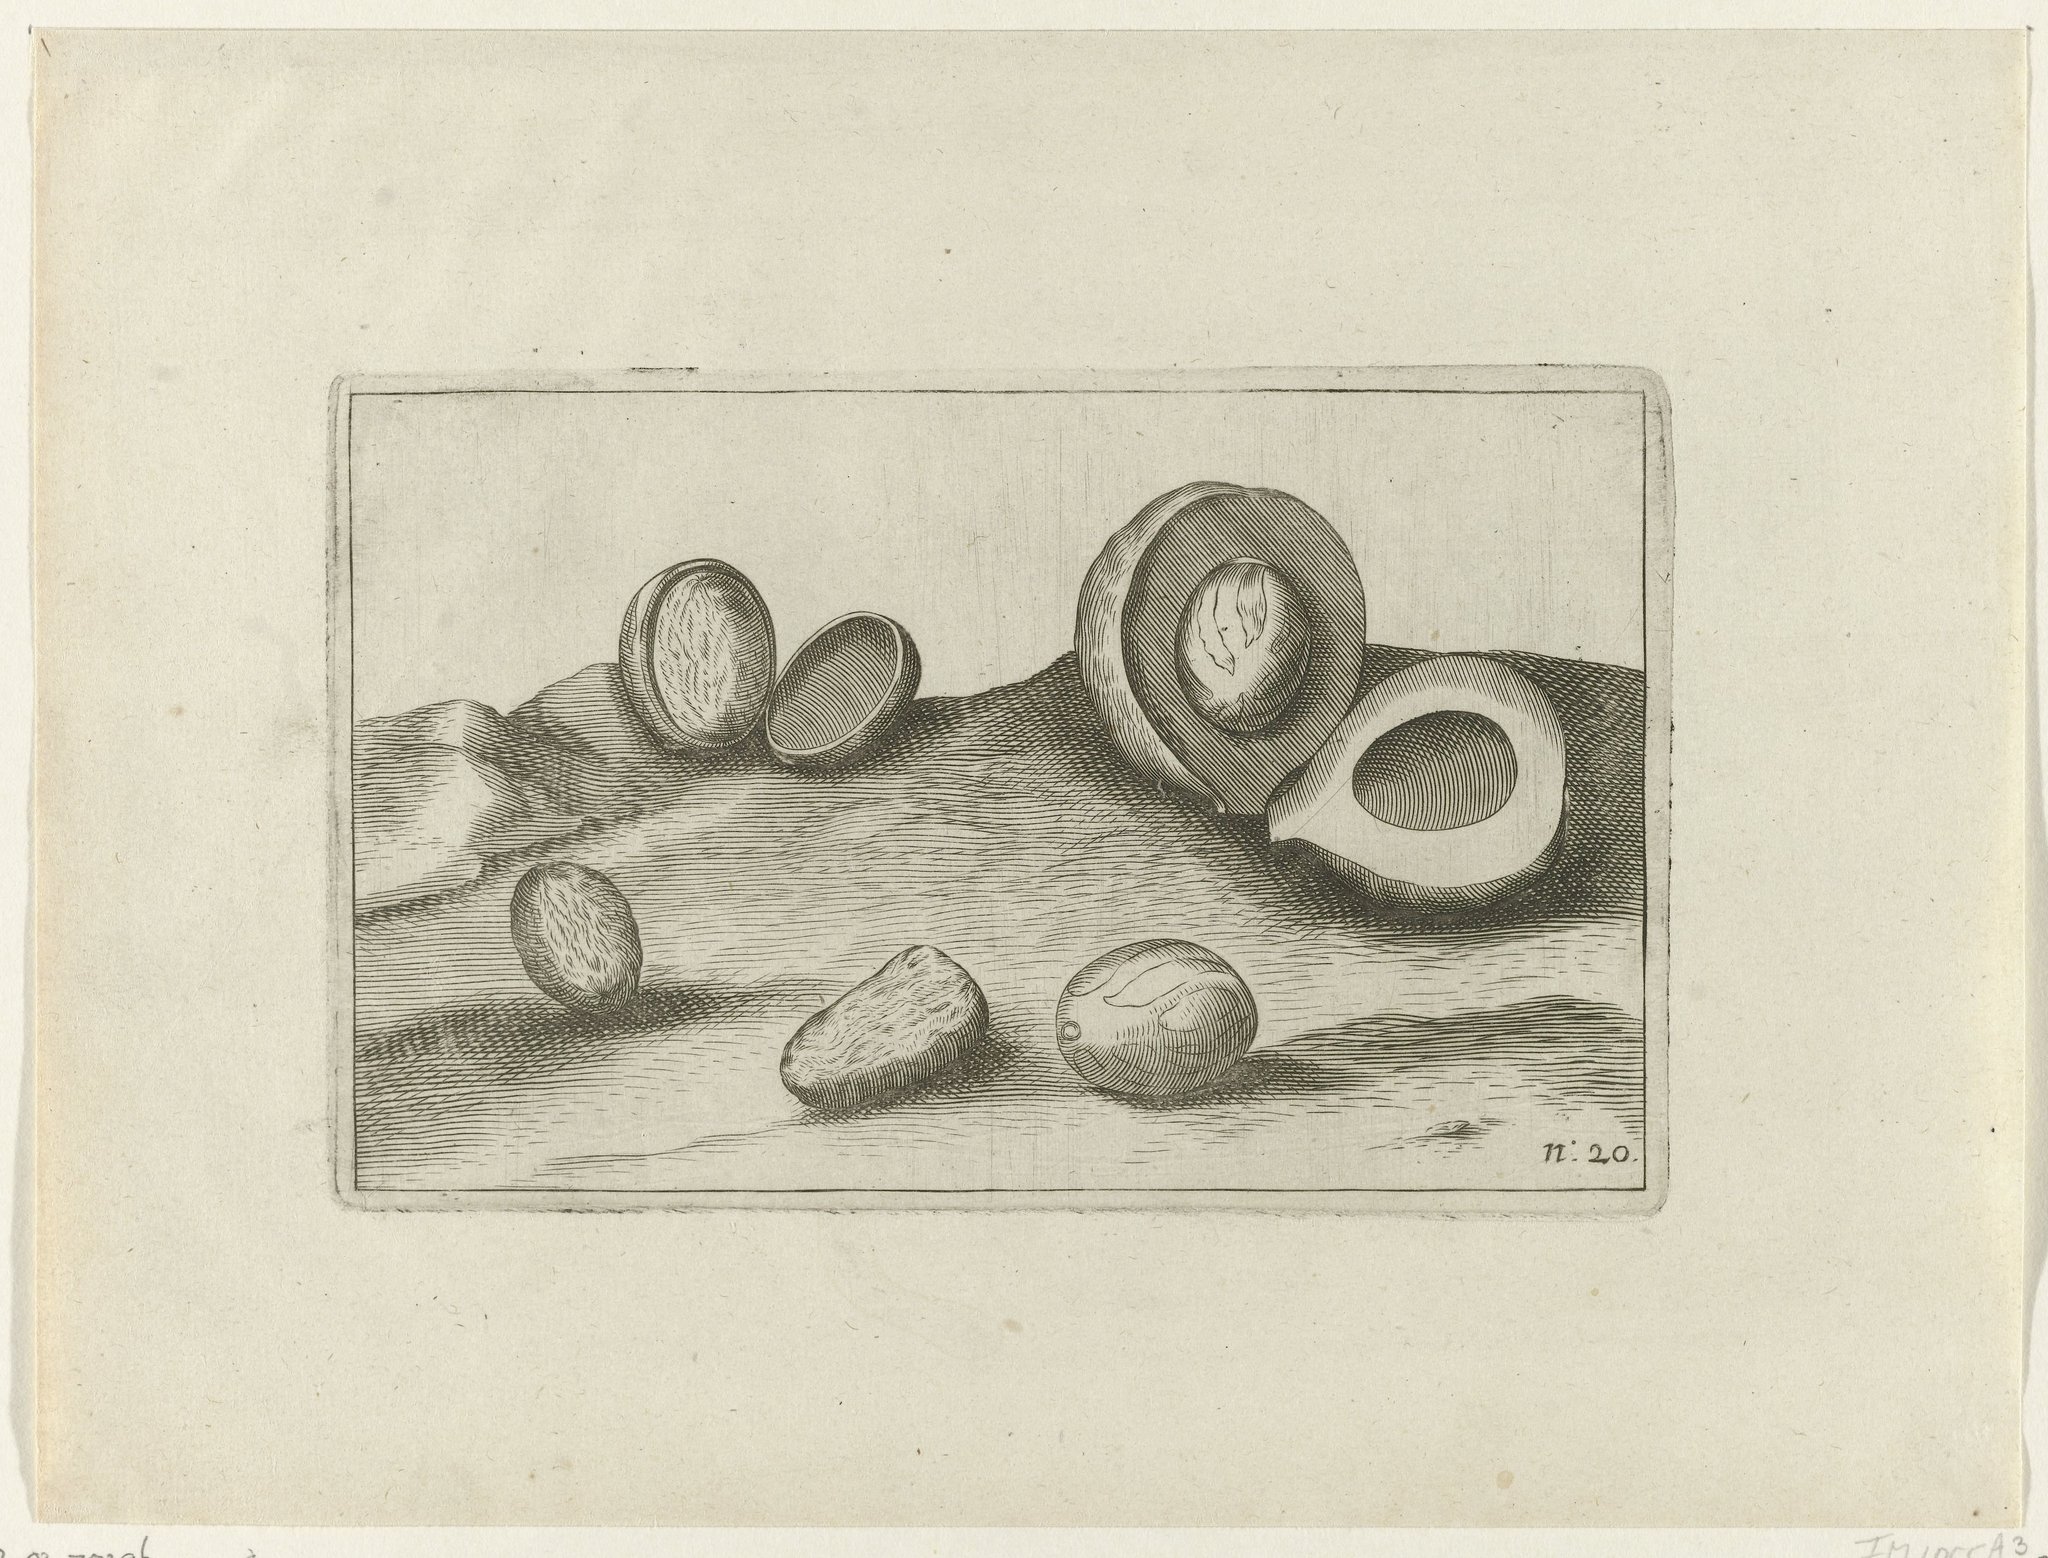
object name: print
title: Nootmuskaat van de Banda-eilanden, 1599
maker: Anonymous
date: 1619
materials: paper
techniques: engraving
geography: northern netherlands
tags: mayor, seasonings, spices (with name), landscapes in tropical and sub-tropical regions, exploration, expedition, voyage of discovery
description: Het origineel voor deze prent eerst gebruikt als illustratie in: J. van Neck en W. van Warwijck, Het tweede boeck, iournael oft dagh-register, inhoudende een warachtich verhael ende historische vertellinghe vande reyse, gedaen door de acht schepen van Amstelredamme, gheseylt inden maent martij 1598. onder 't beleydt vanden admirael Iacob Cornelisz. Neck, ende Wybrandt van Warwijck als vice-admirael / Appendix. Vocabulaer vande Javaensche ende Malaysche woorden ..., Cornelis Claes, Amsterdam 1601, ongenummerde plaat. Deze kopie gebruikt in: Oost-Indische ende West-Indische voyagien, Michiel Colijn, Amsterdam 1619 en later in: Waerachtigh verhael van de Schipvaerd op Oost-Indien ghedaen by de acht Schepen in den jare 1598 van Amsterdam uyt-ghezeylt, onder 't beleyd van den Admirael Jacob Cornelissoon van Neck, ende Vice-Admirael Wybrand van Warwijck. Opgenomen in: I. Commelin, Begin ende voortgangh, van de Vereenighde Nederlantsche Geoctroyeerde Oost-Indische Compagnie, J. Janssonius, Amsterdam 1646. Genummerd: 20.